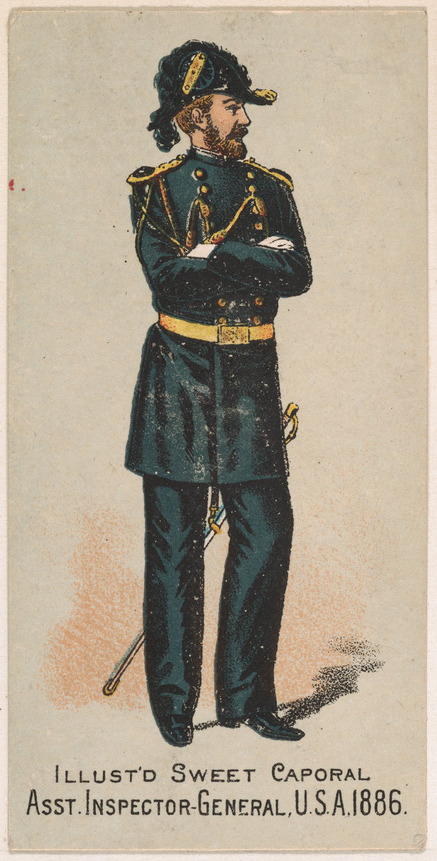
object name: print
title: Assistant Inspector-General, United States Army, 1886, from the Military Series (N224) issued by Kinney Tobacco Company to promote Sweet Caporal Cigarettes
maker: kinney brothers tobacco company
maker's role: publisher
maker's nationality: american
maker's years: 1869-2011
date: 1888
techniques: color lithograph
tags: men,profiles,generals